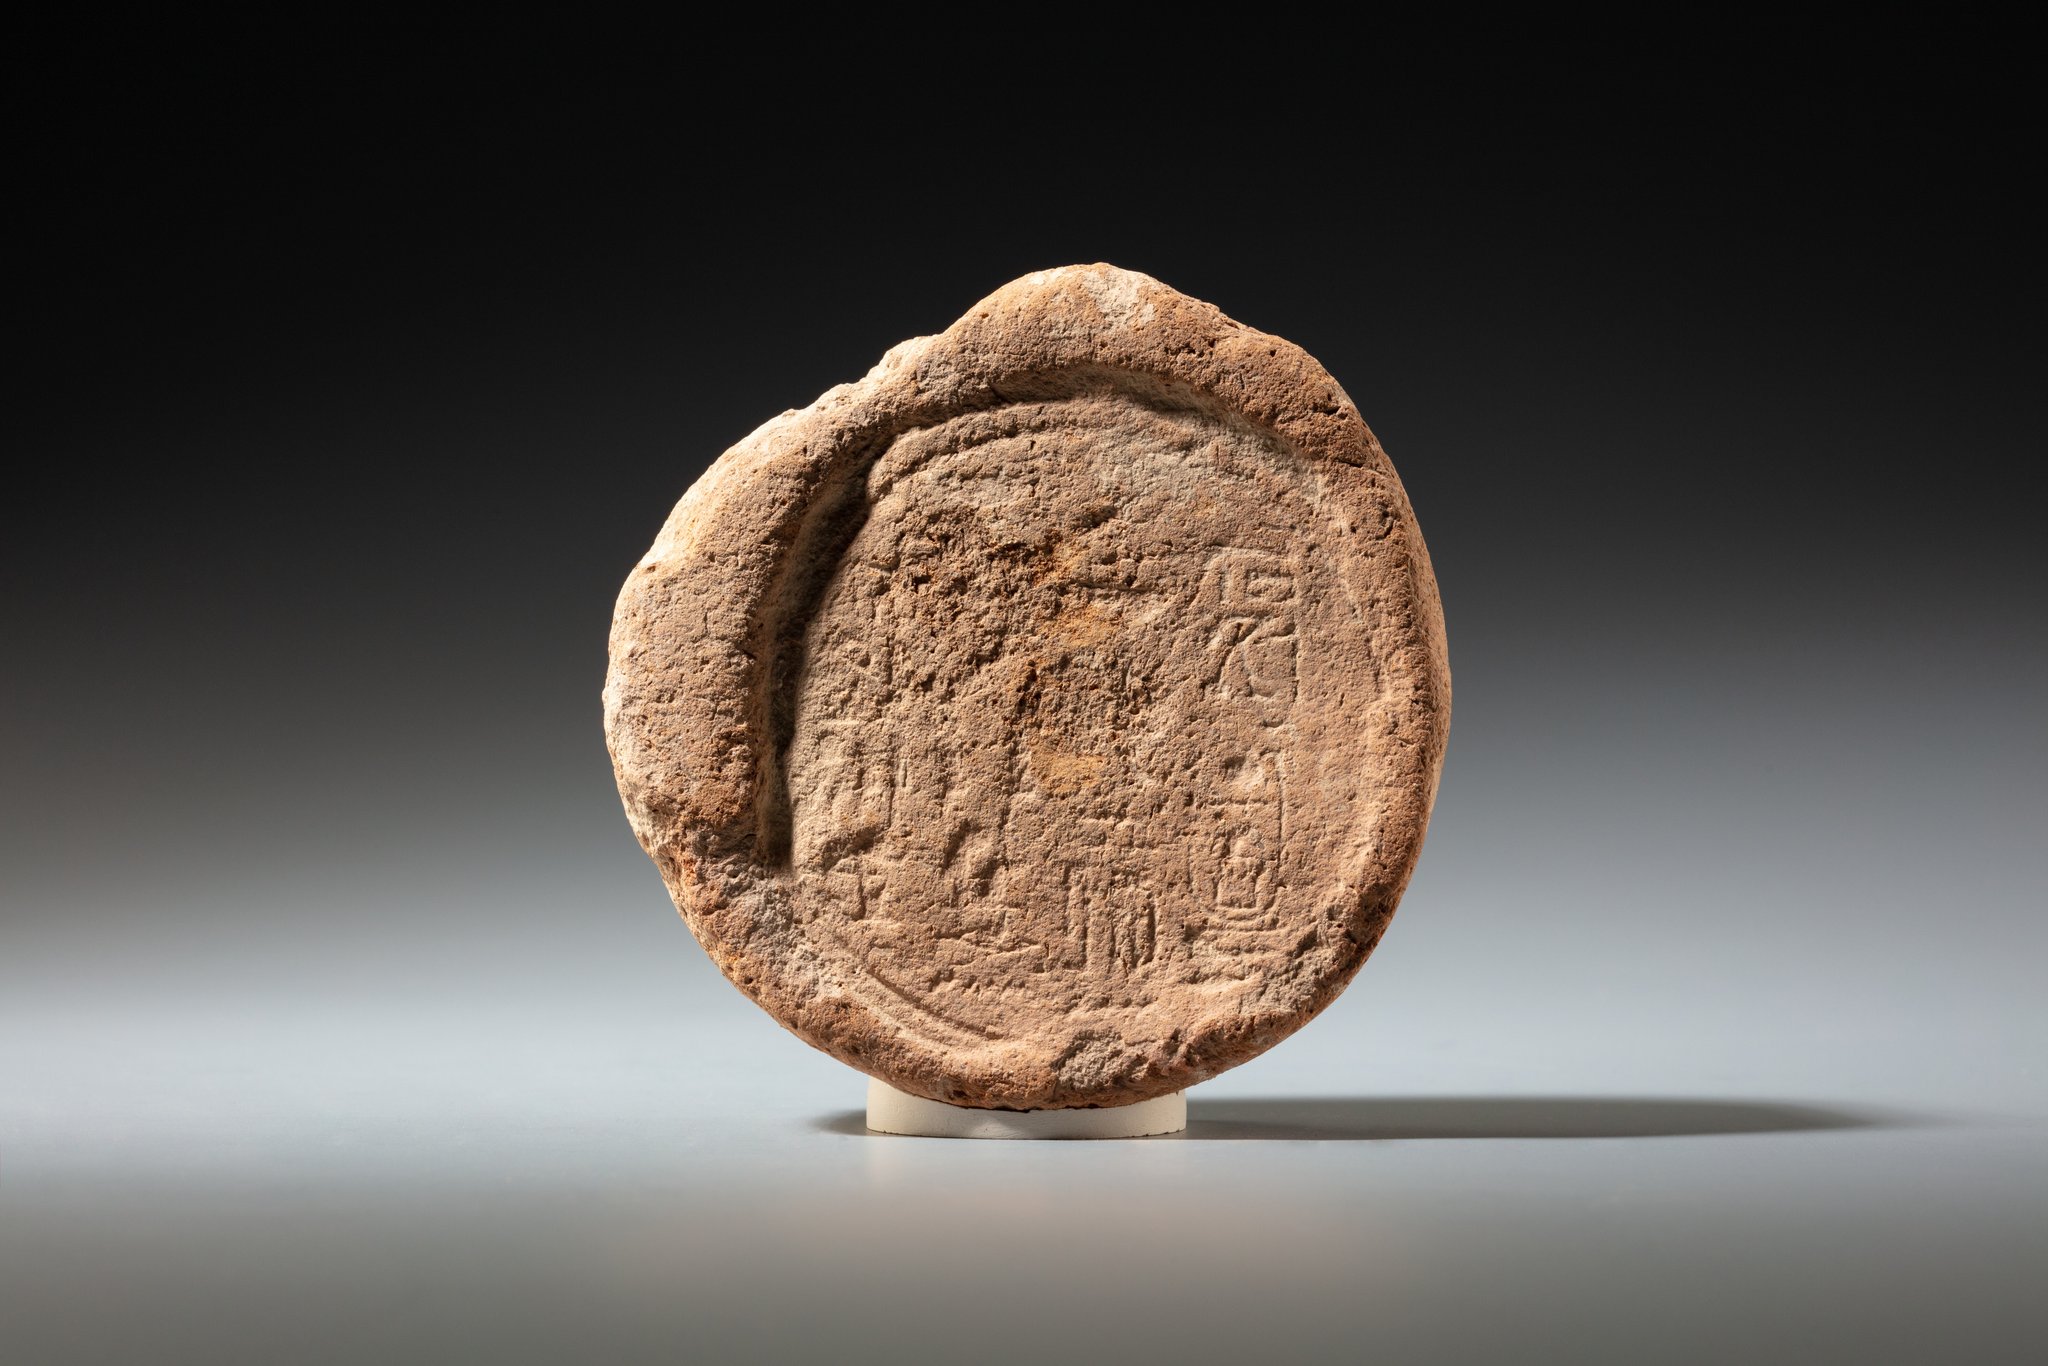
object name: cone, circular impression, bak, steward, thutmose i, nay, house mistress, aye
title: Funerary Cone of the Steward Bak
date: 1504-1492 BCE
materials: pottery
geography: egypt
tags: hieroglyphs